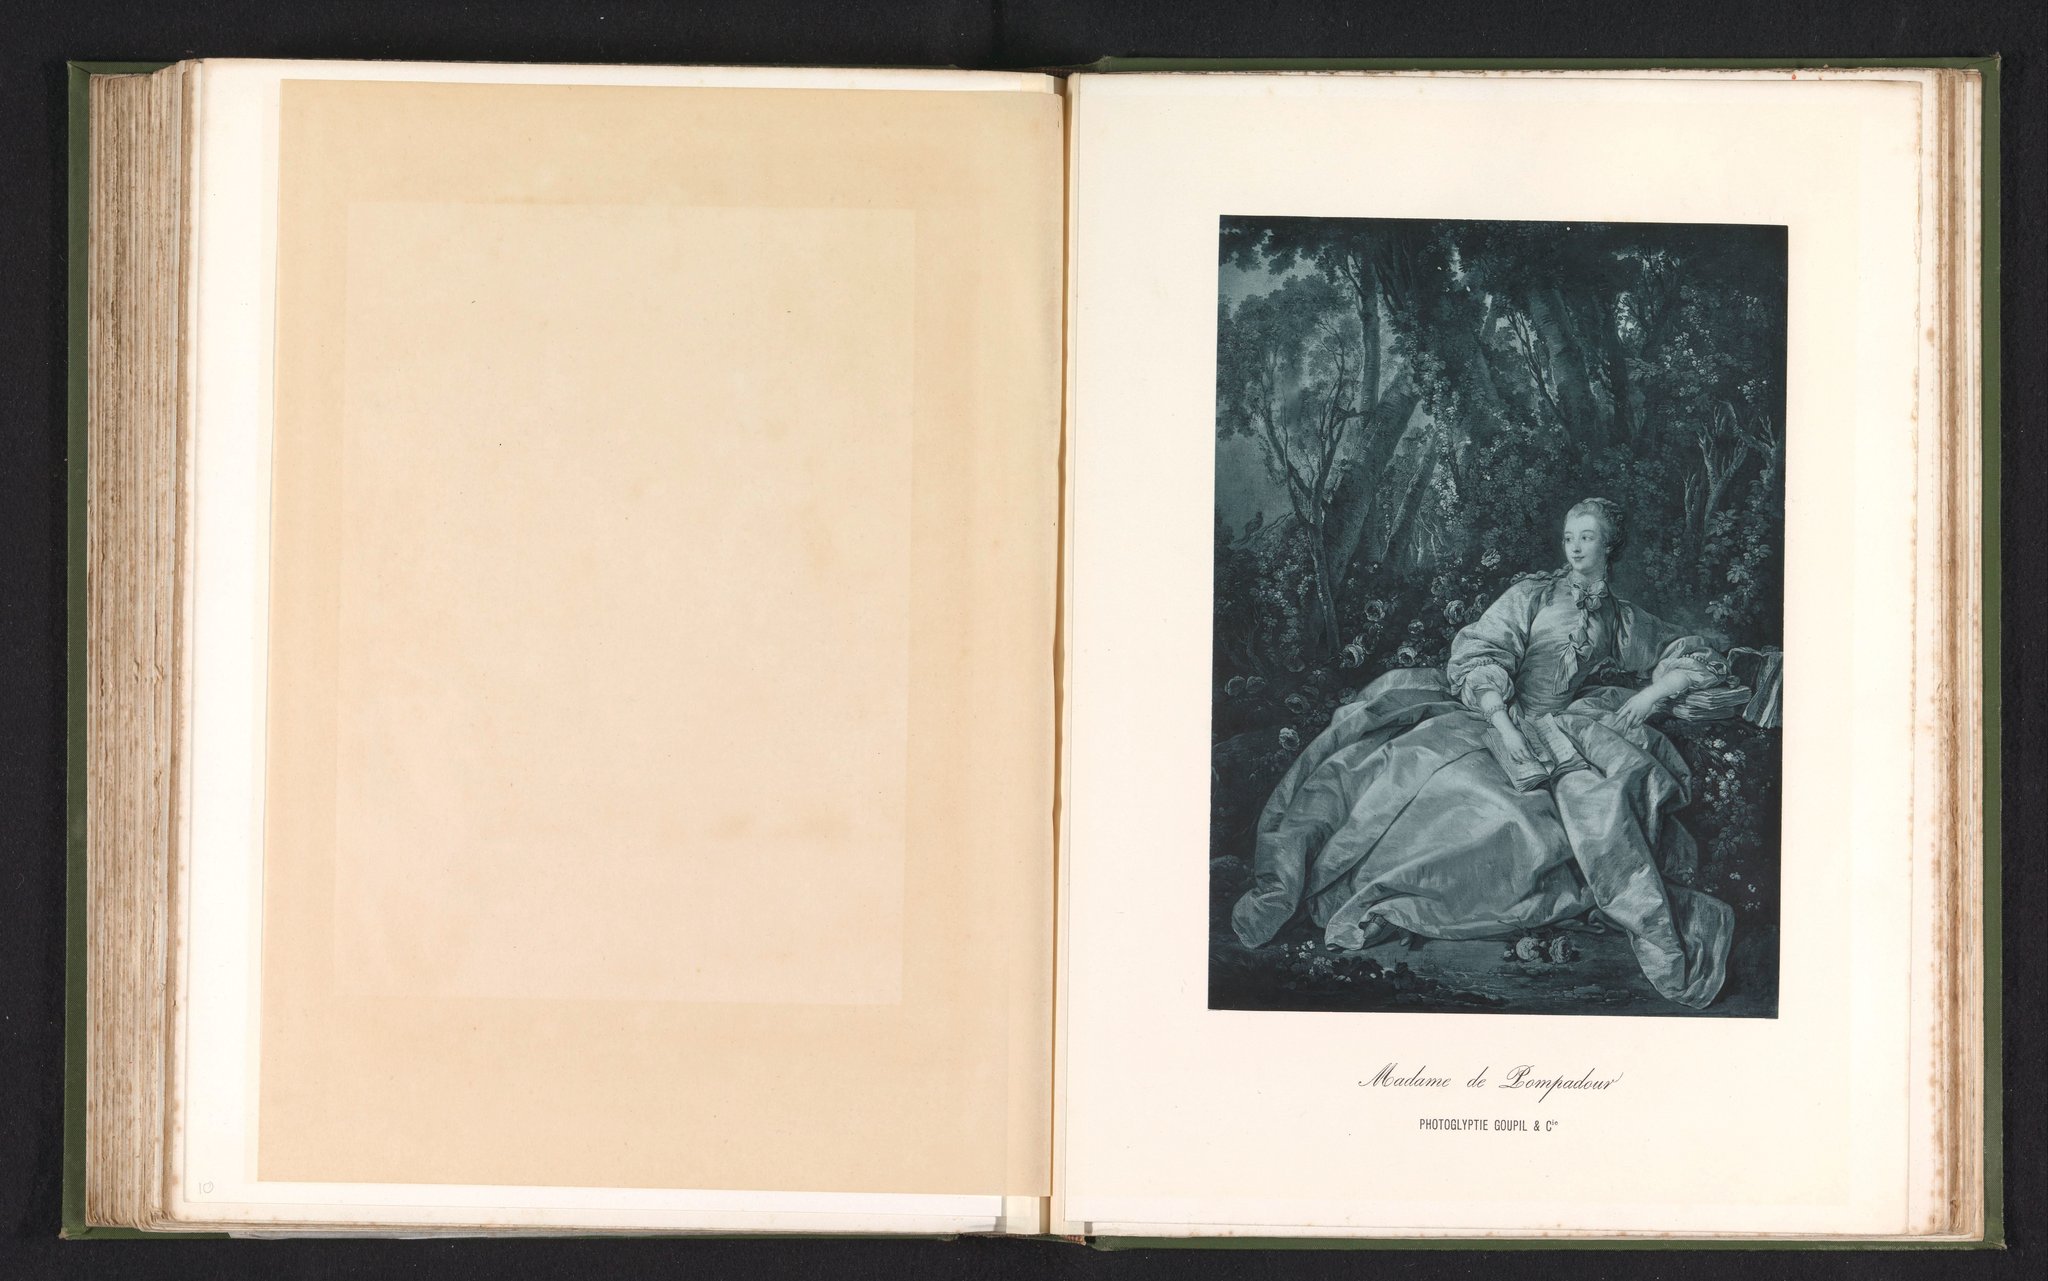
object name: photomechanical print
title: Madame de Pompadour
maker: Anonymous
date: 1871-1881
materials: paper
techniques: woodburytype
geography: france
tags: paris, print maker, madame de pompadour, historical persons - bb - woman (+ full length portrait), forest, wood